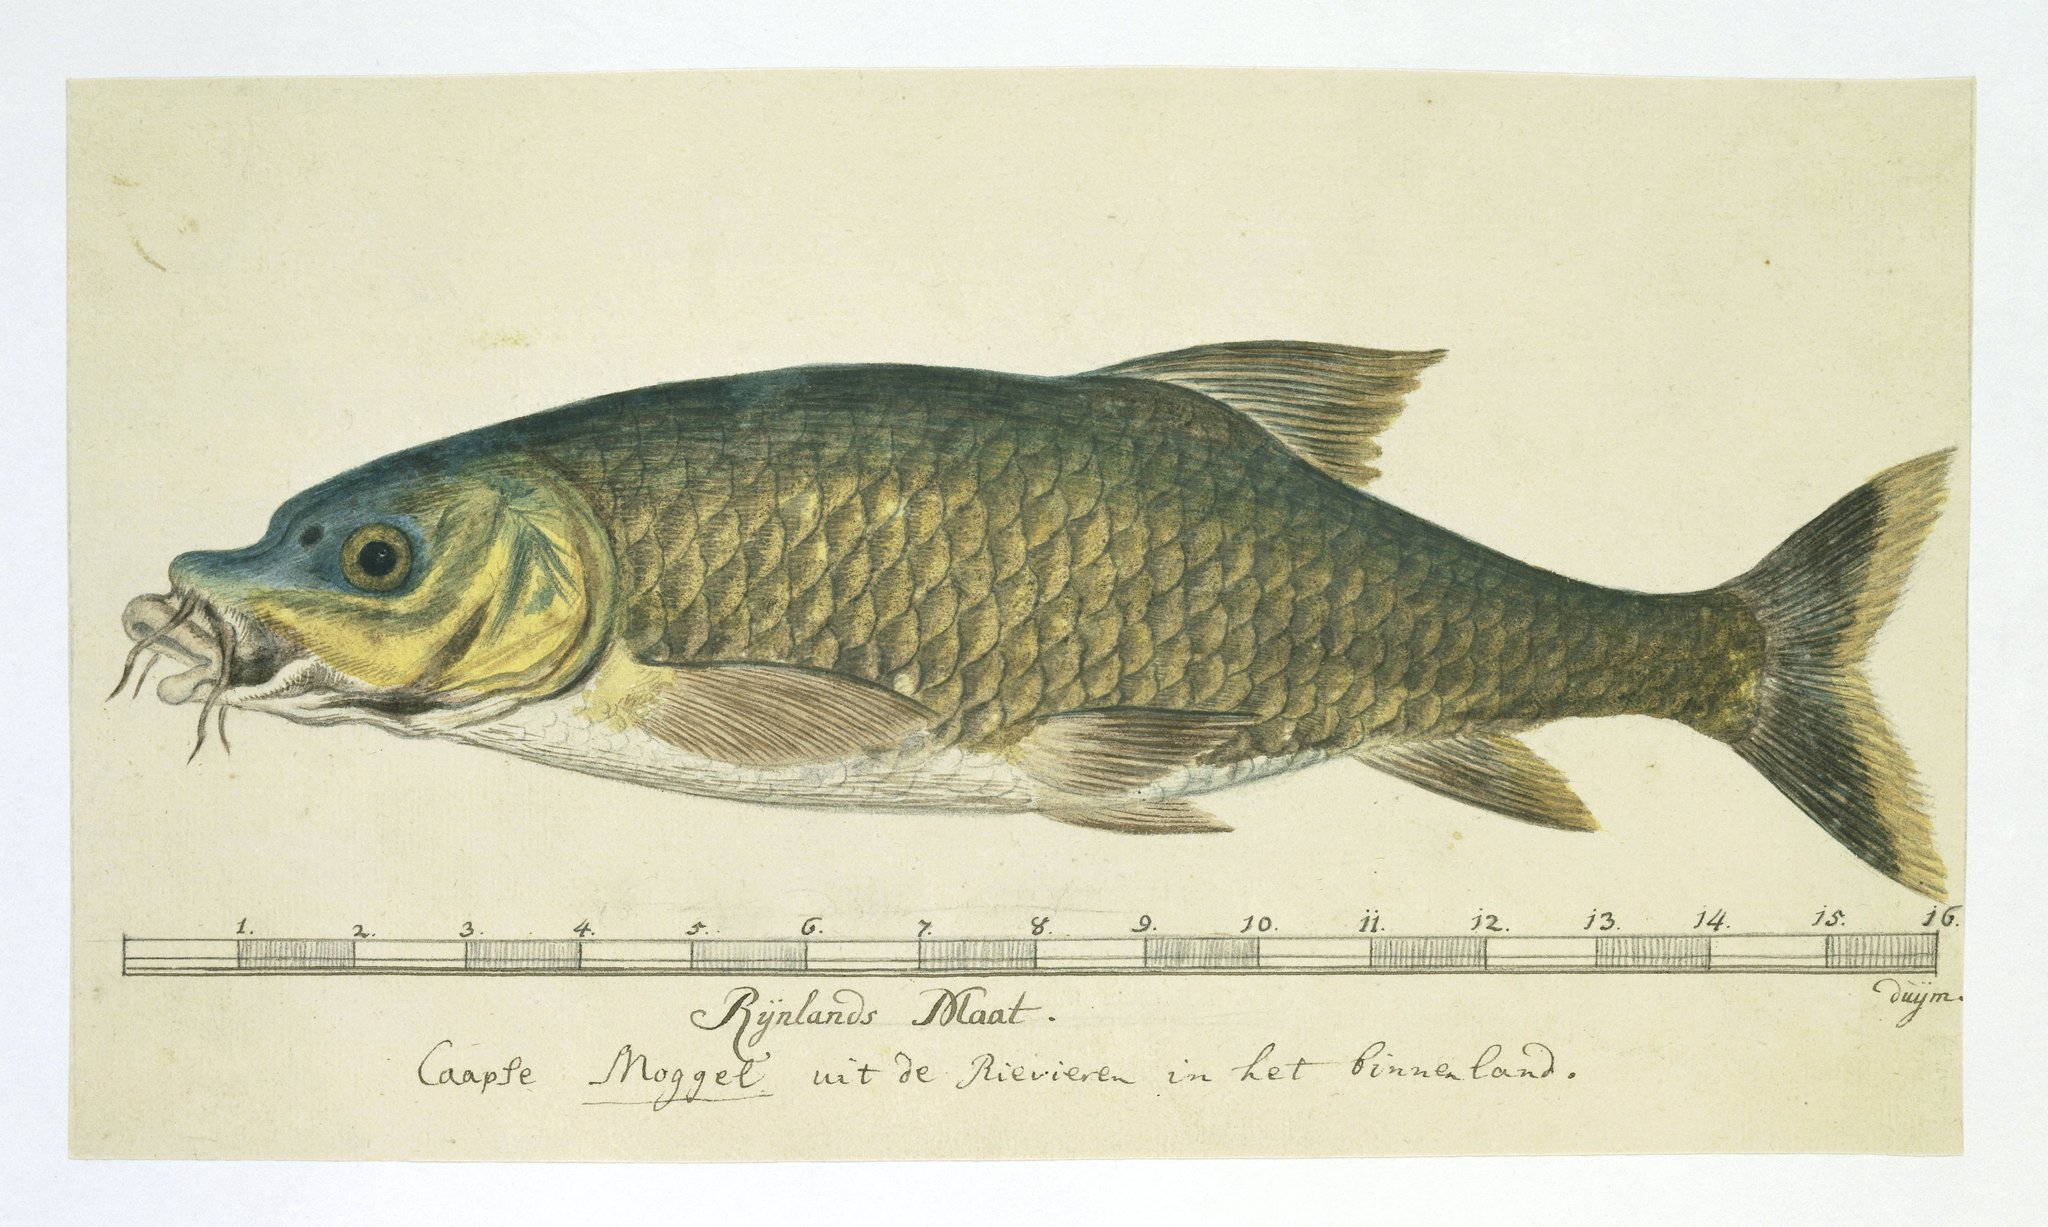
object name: dierstudie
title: Labeo umbratus (Cape moggel)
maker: robert jacob gordon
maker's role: draughtsman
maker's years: 1743-1795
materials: chalk, paper, pencil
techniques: brush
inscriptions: annotation: ‘Rijnlands Maat. / Caapse Moggel [onderstreept] uit de Rievieren in het binnenland.’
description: Kaapse moggel of harder (Labeo umbratus); met schaalverdeling in Rijnlandse duimen.